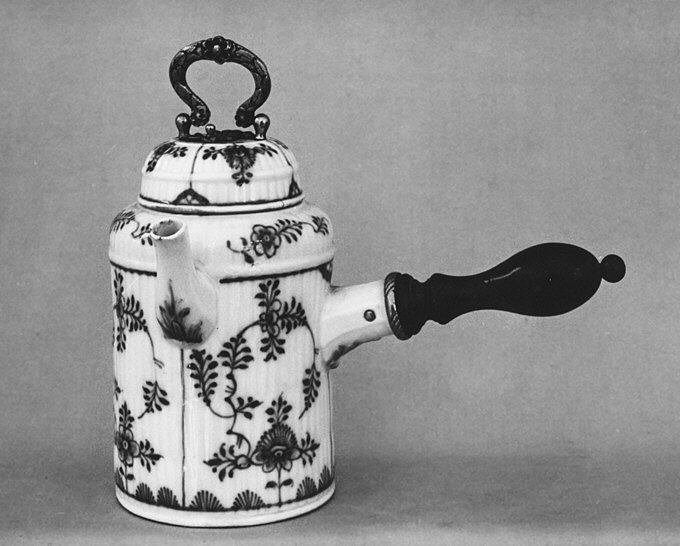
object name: chocolate pot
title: Chocolate pot (part of a set)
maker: meissen manufactory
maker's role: manufactory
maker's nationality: german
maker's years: 1710-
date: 1740-1750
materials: hard paste porcelain